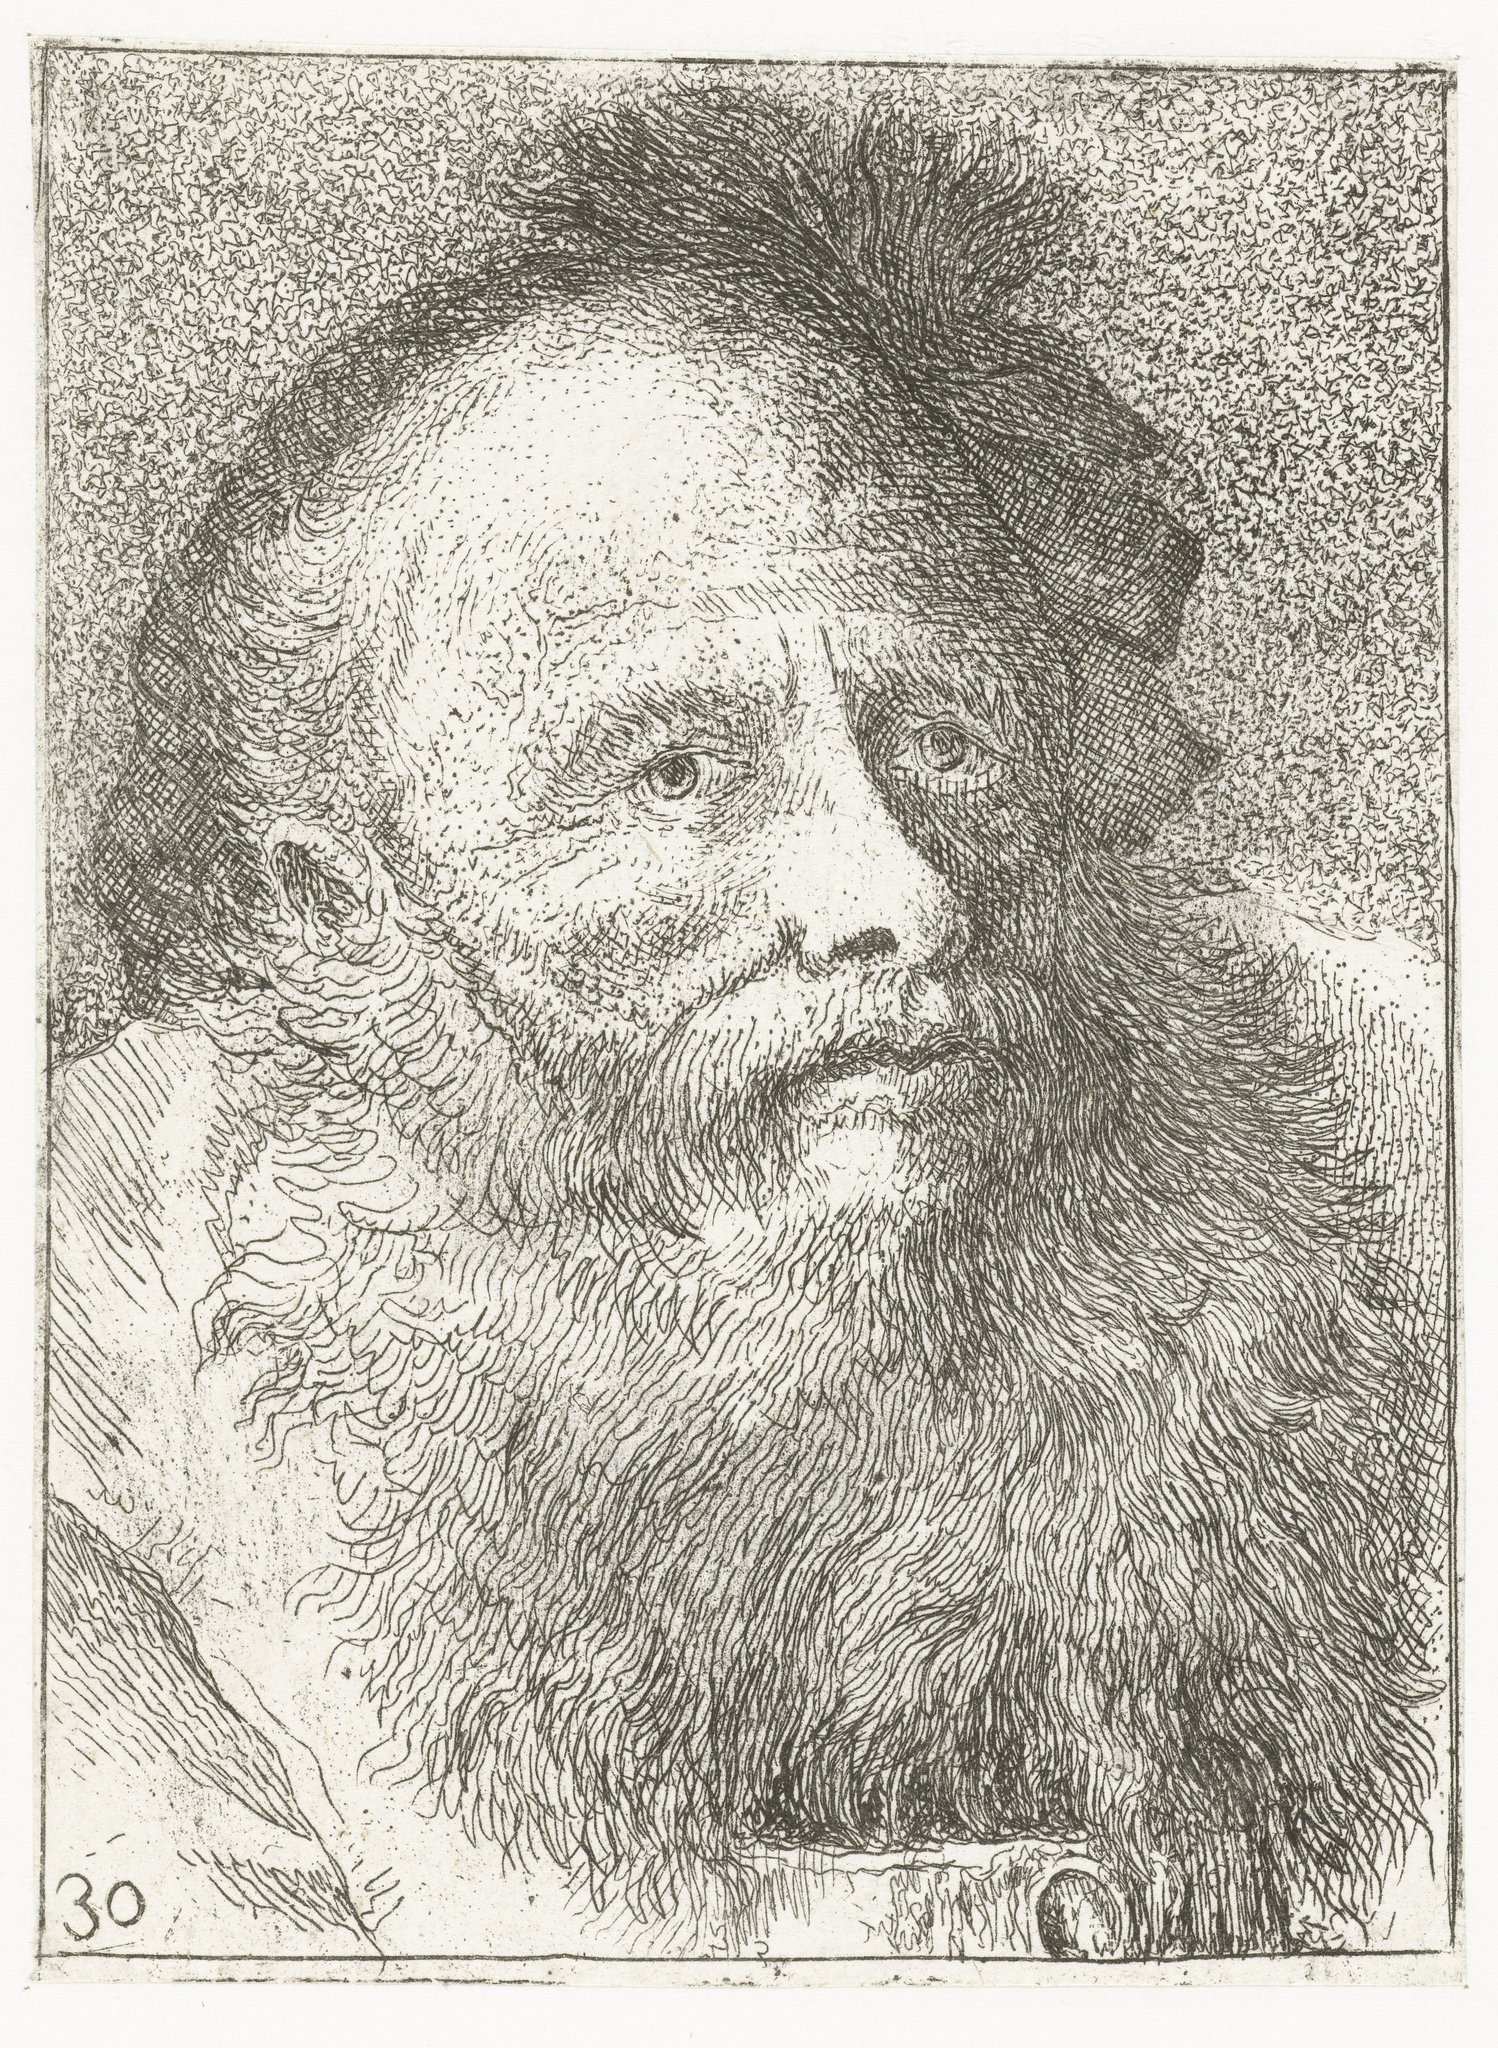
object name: print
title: Man met baard en hoofddeksel met veer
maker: giovanni domenico tiepolo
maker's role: draughtsman, print maker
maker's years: 1727-1804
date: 1771-1774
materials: paper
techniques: etching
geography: venice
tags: person with big beard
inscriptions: collector's mark: Lugt 2228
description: Prent uit serie Verzameling hoofden (Raccolta di teste). Giovanni Domenico Tiepolo vervaardigde in de winter van 1757-1758 en in de periode van 1771-1774 deze hoofden naar schilderijen en tekeningen van Giovanni Battista Tiepolo. De eerste uitgave verscheen in 1774 in twee delen met elk dertig prenten. Deze prent werd opgenomen in deel 2.